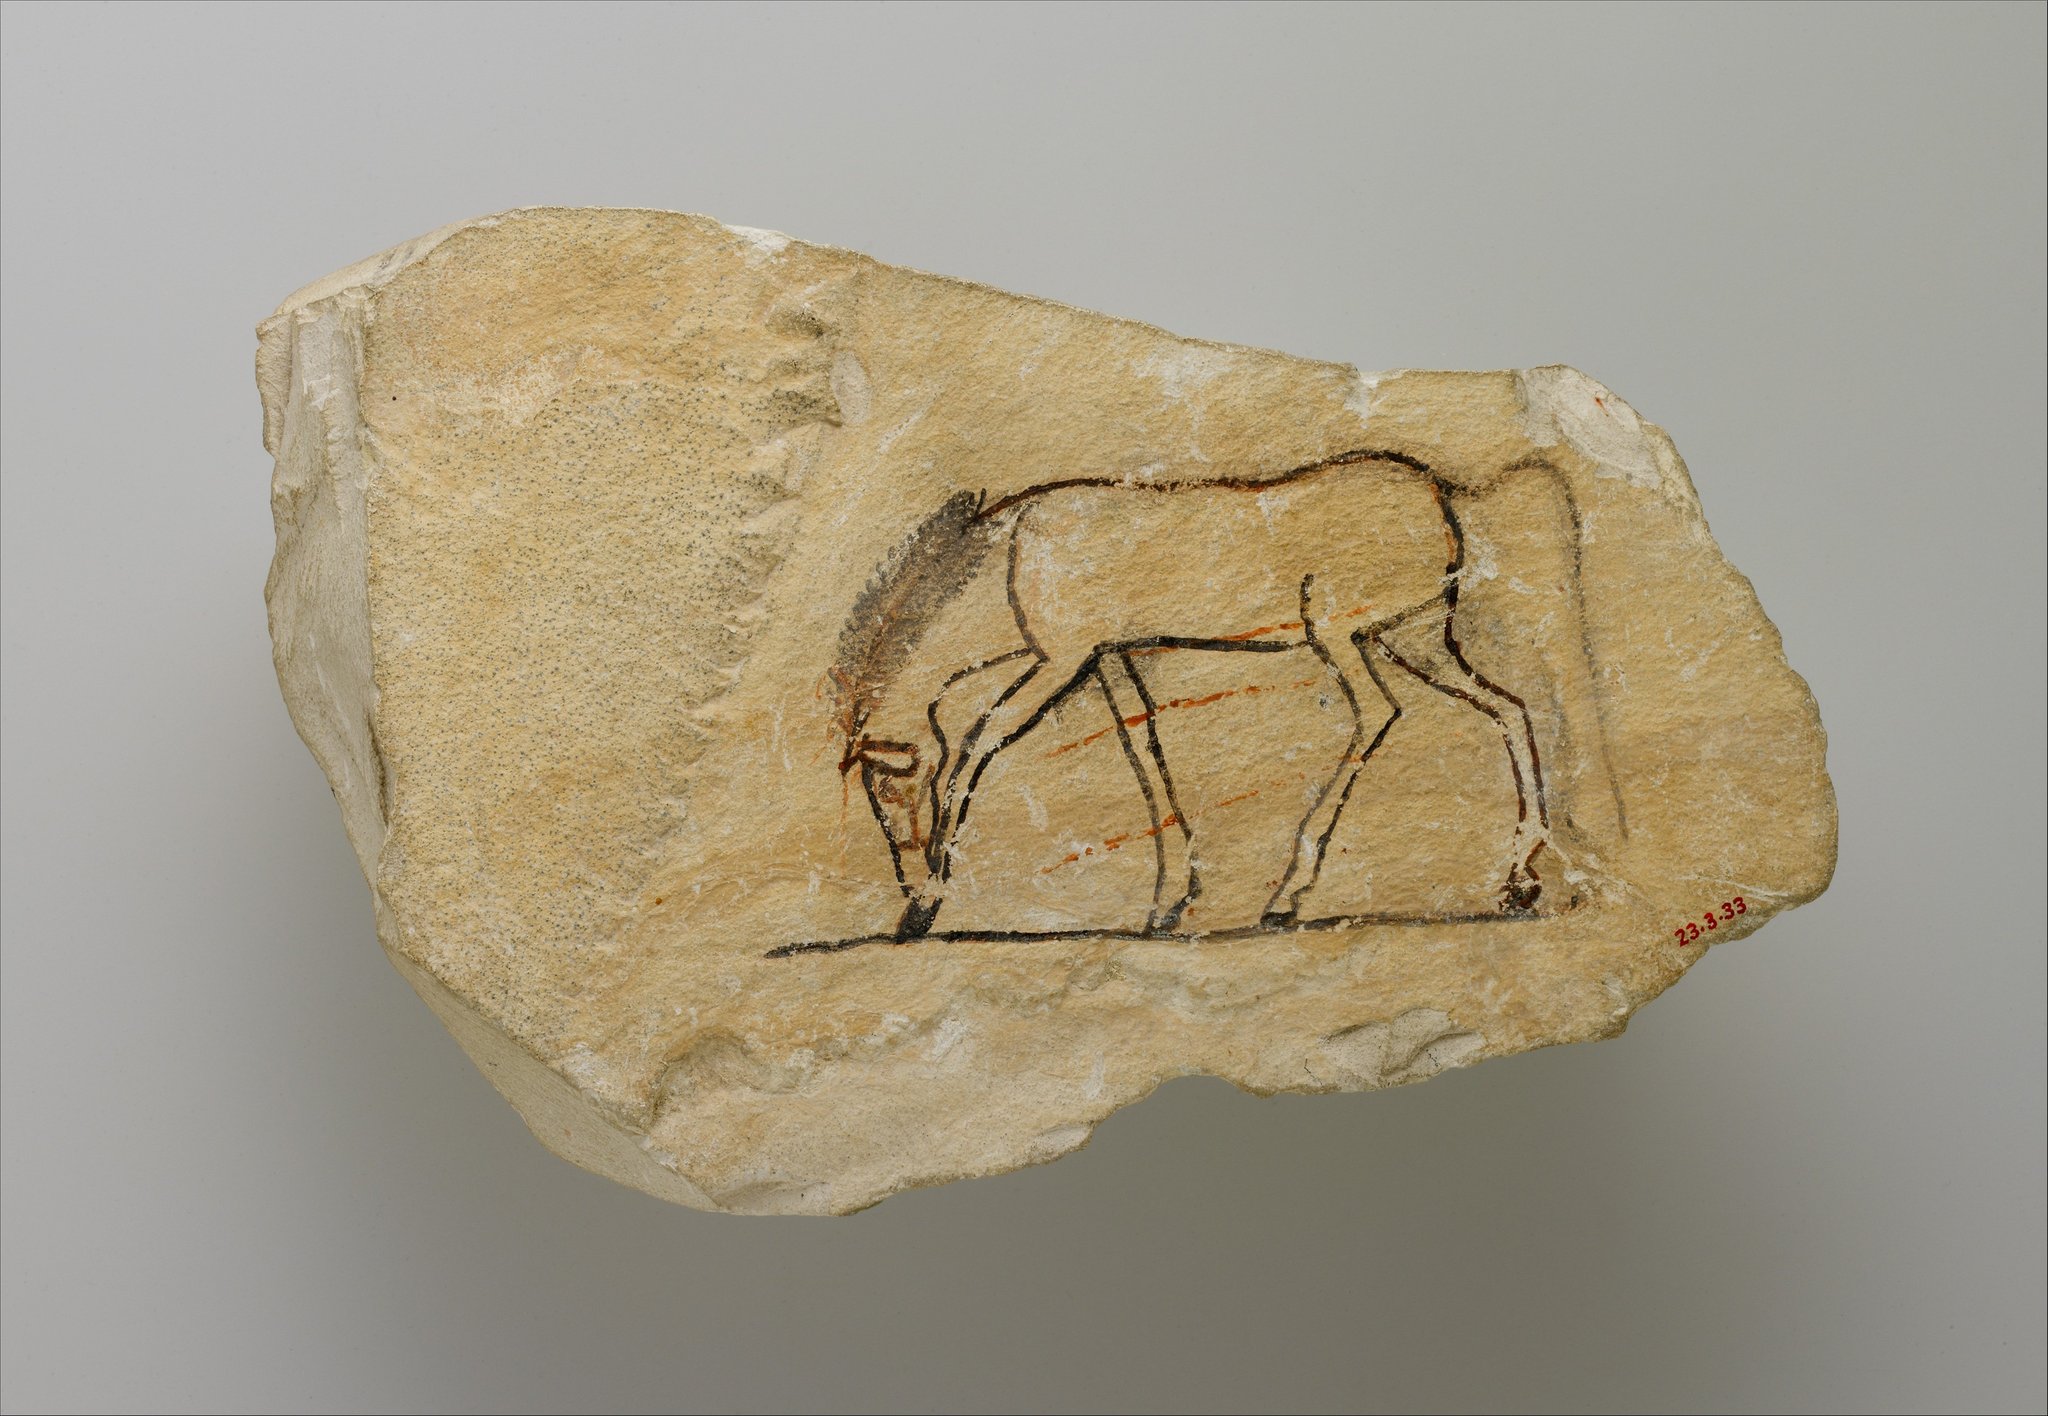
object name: ostracon, figured, horse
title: Artist's Sketch of a Horse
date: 1295-1070 BCE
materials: ink, limestone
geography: egypt